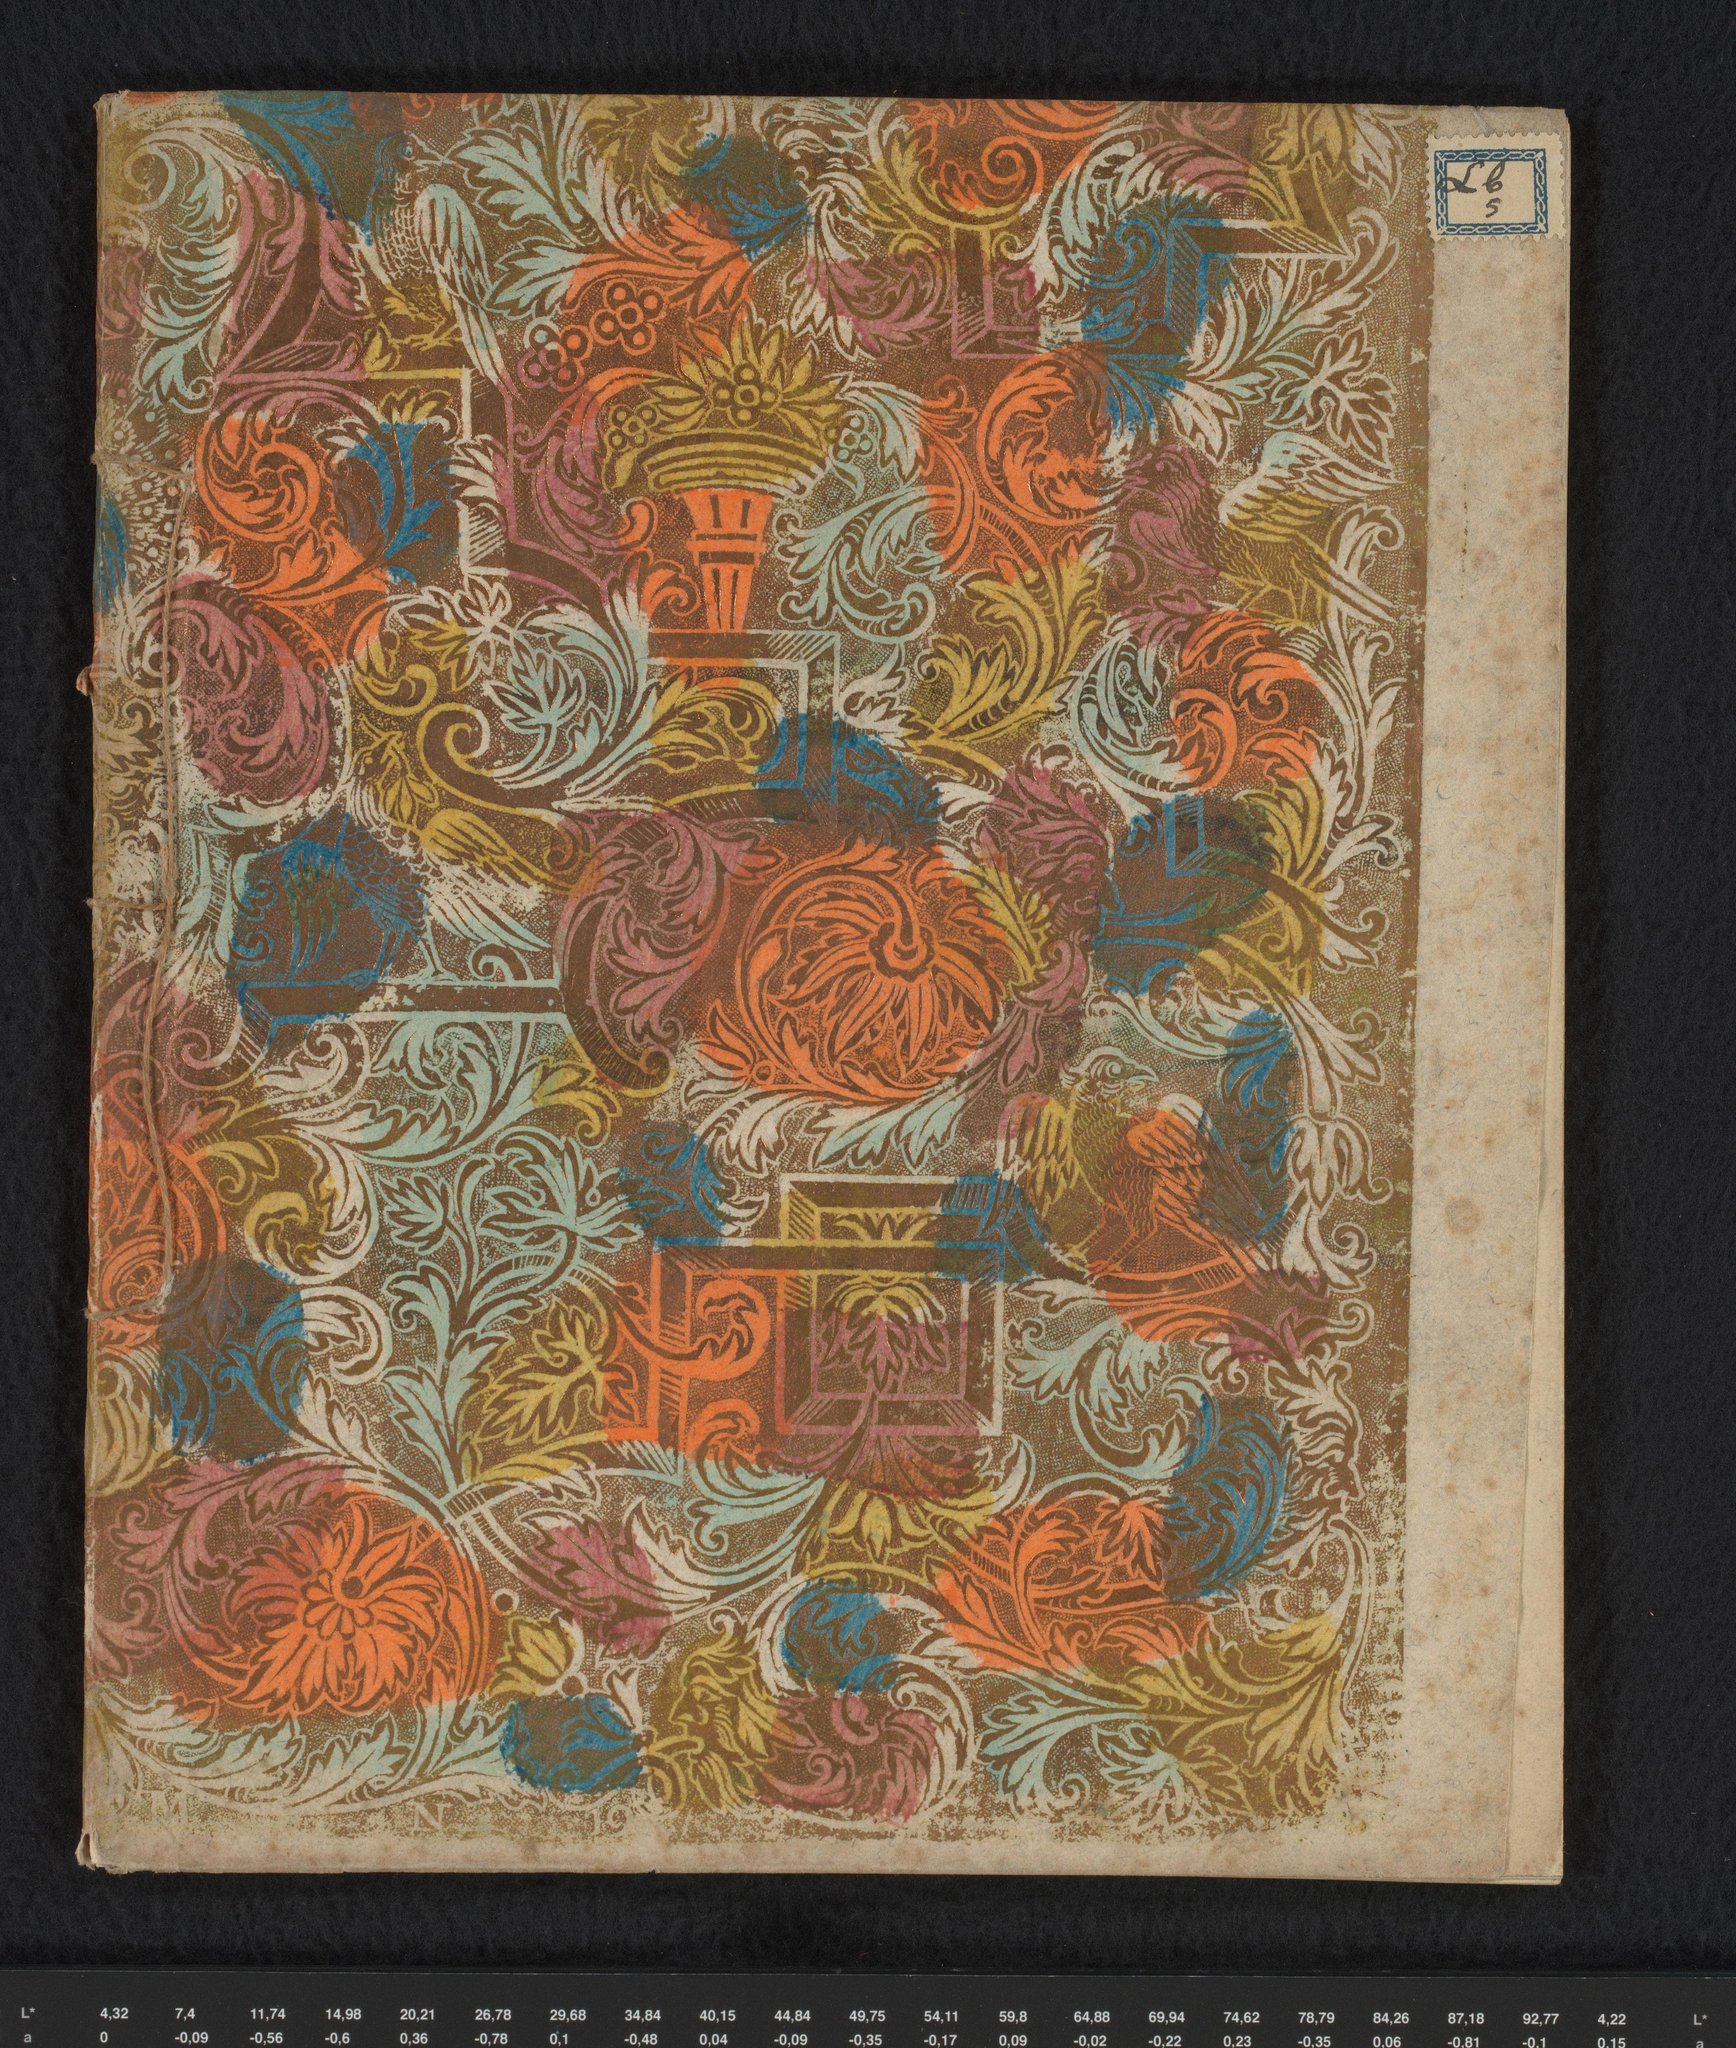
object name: brocade paper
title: Specimen antiquario-juridicum inaugurale, sistens Animadversiones quasdam criticas ad Diplomata quaedam a Mattheaeo edita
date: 1788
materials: gold leaf, paint, paper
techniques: letterpress printing, relief print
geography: augsburg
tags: utrecht, johan gerard swellengrebel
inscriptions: name: ‘IM N 19’, label: ‘Lb 5’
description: Specimen antiquario-juridicum inaugurale, sistens Animadversiones quasdam criticas ad Diplomata quaedam a Mattheaeo edita. Proefschrift van Johan Gerard Swellengrebel, Universiteit Utrecht 1788. In omslag van goudbrokaatpapier met bloemen, ranken en vogels. (gemerkt onderaan: IM N 19).